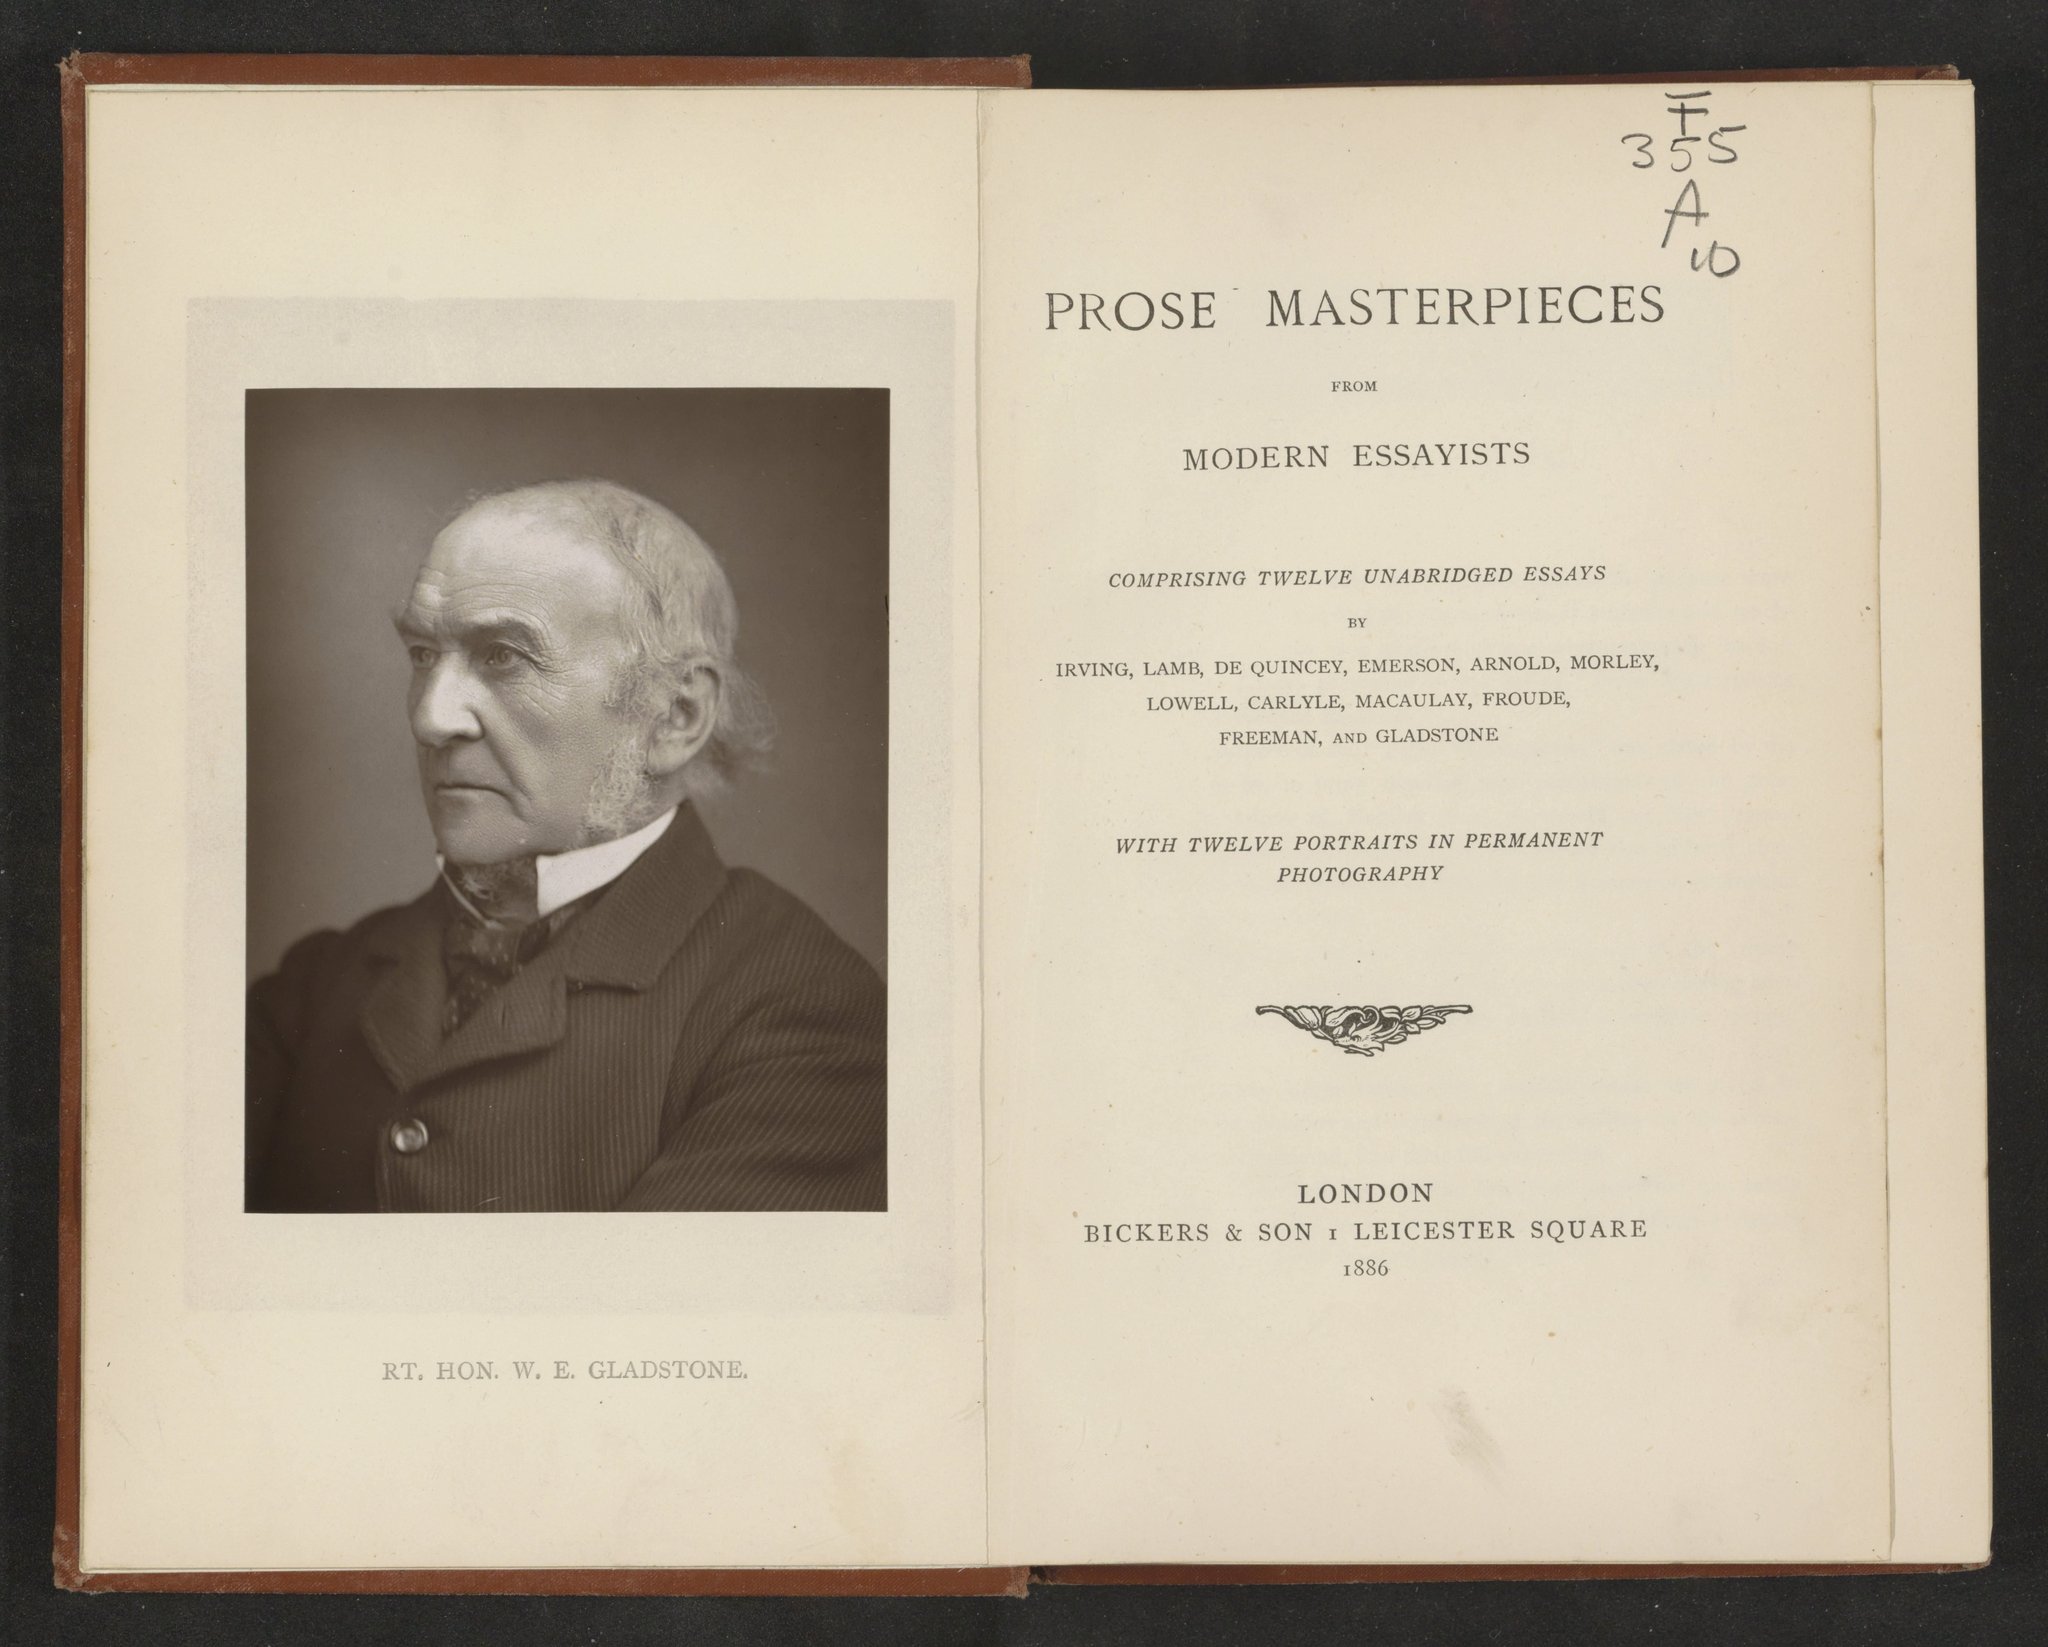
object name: book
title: Prose masterpieces from modern essayists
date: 1886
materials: cardboard, linen, paper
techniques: printing, woodburytype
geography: london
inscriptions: inscription: ‘ex libris SFJ’